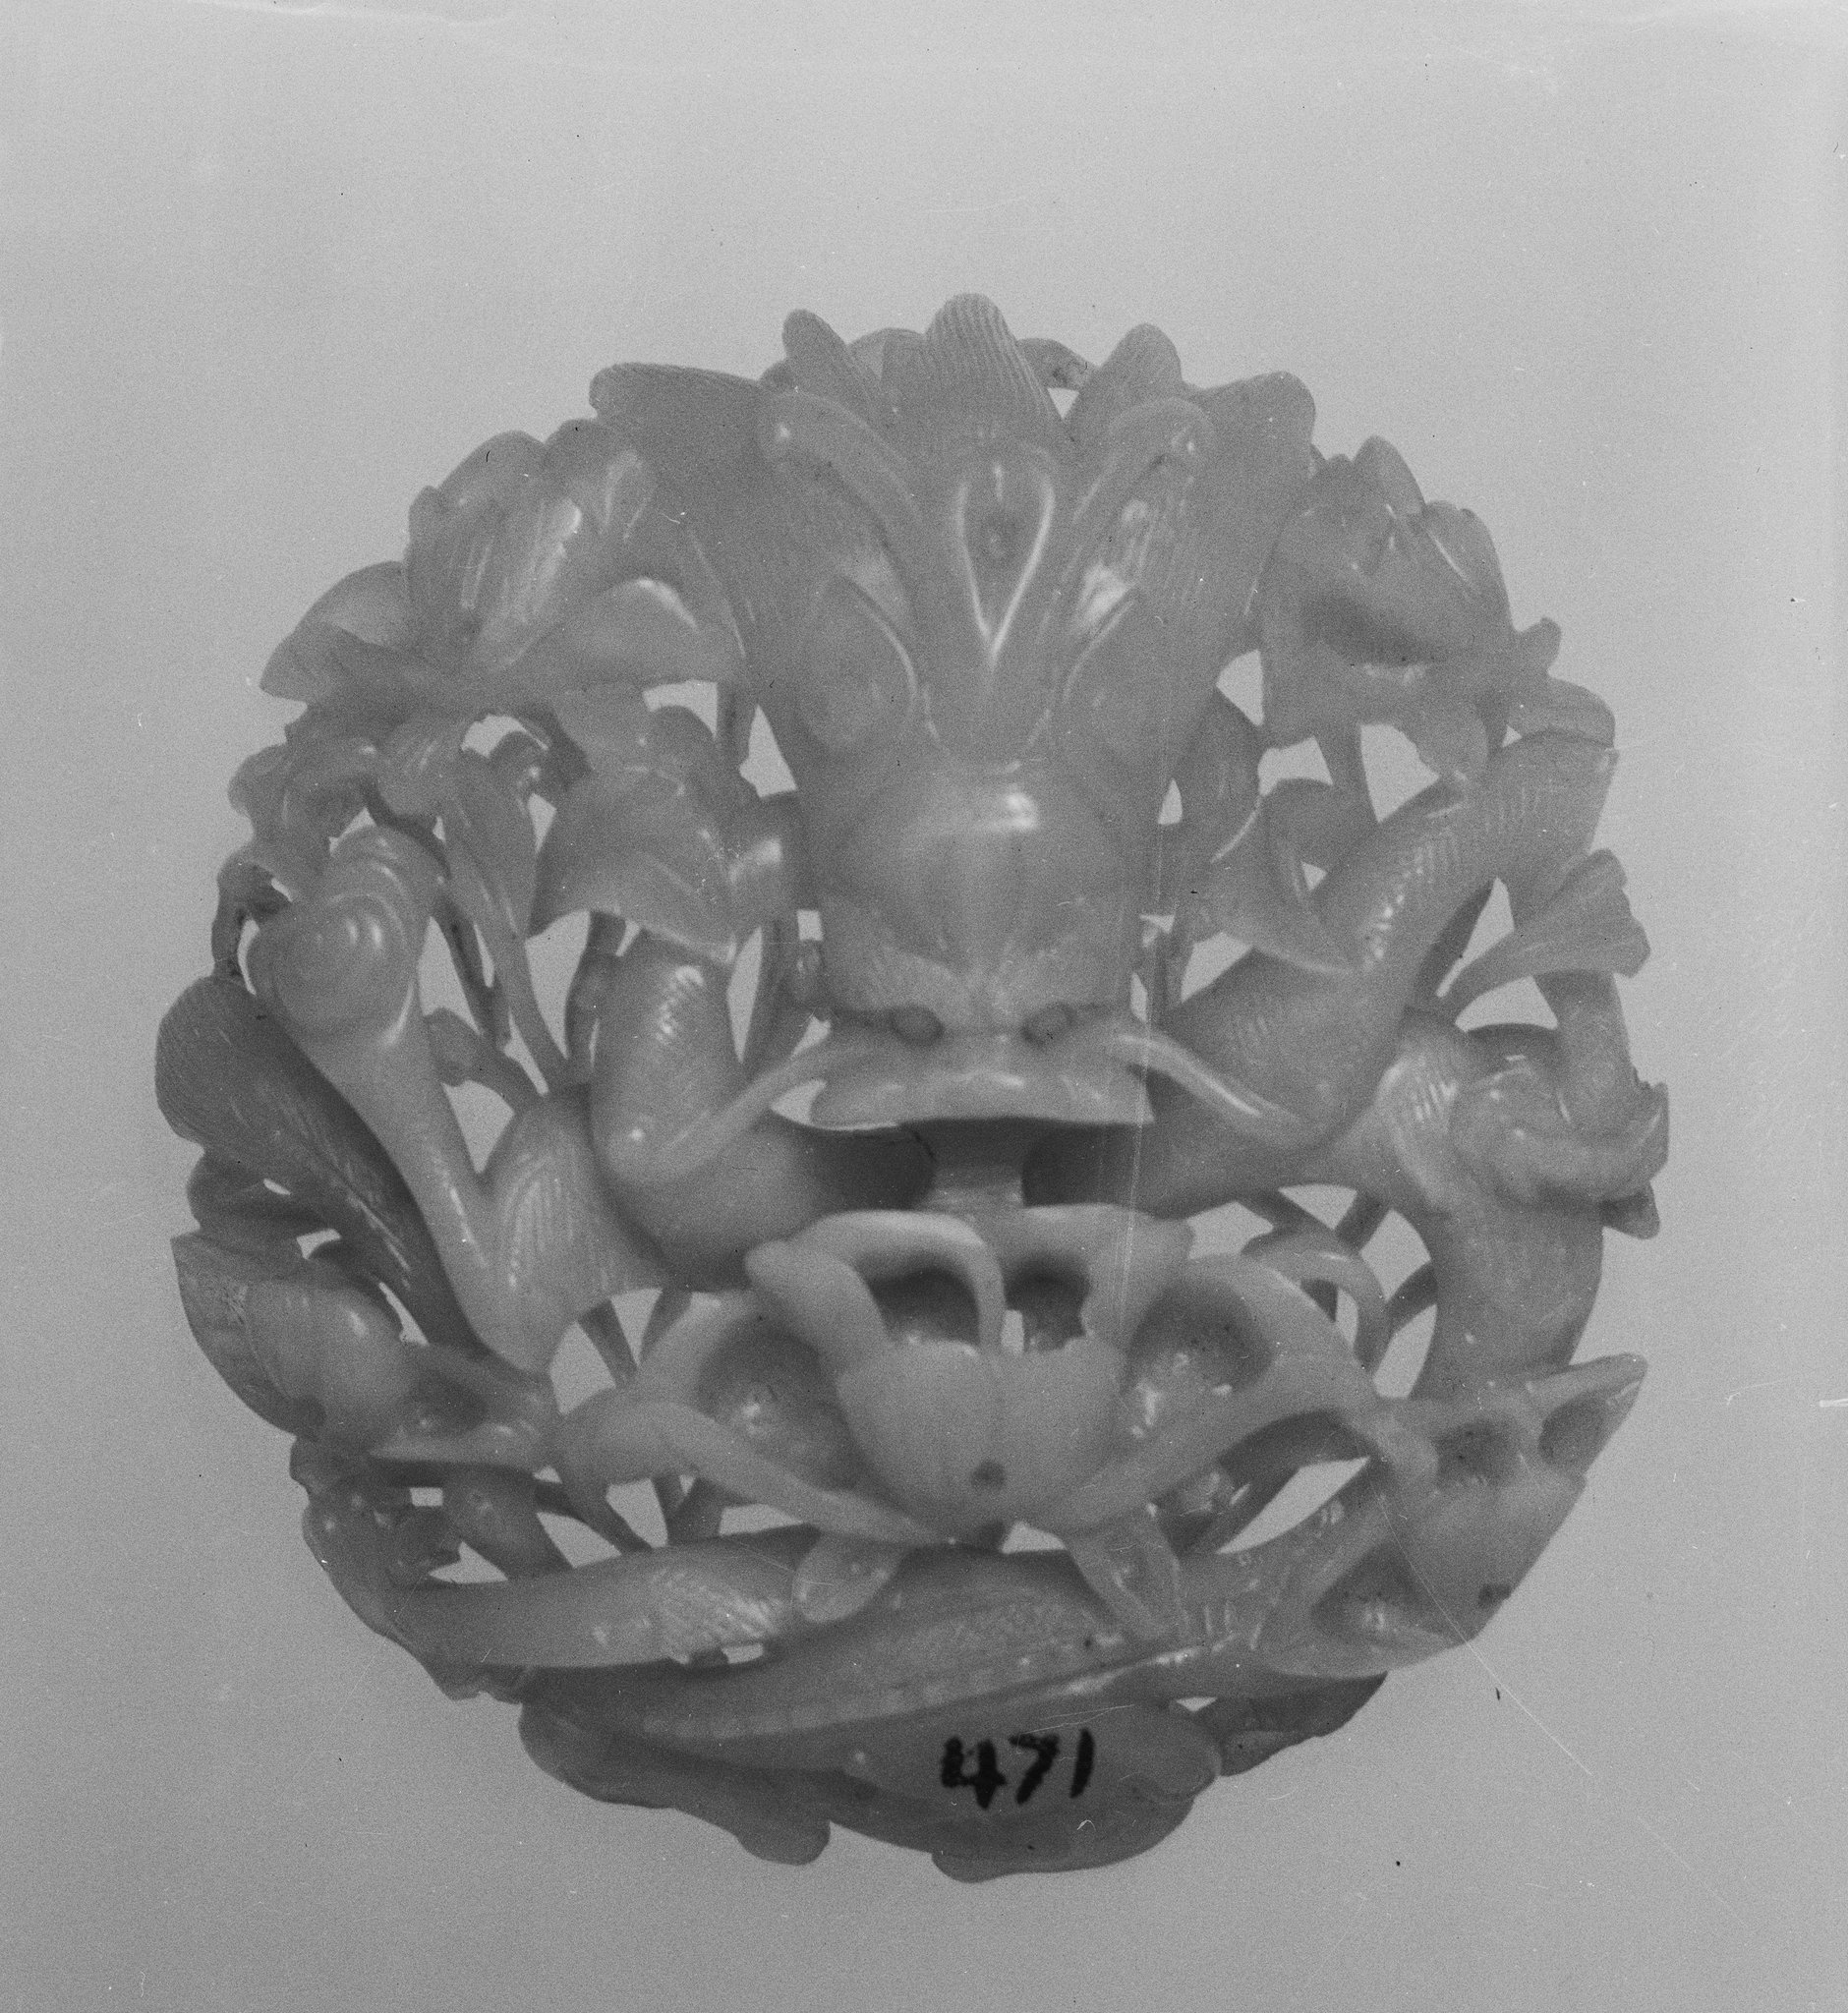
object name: medallion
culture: chinese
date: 1662-1722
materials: jade